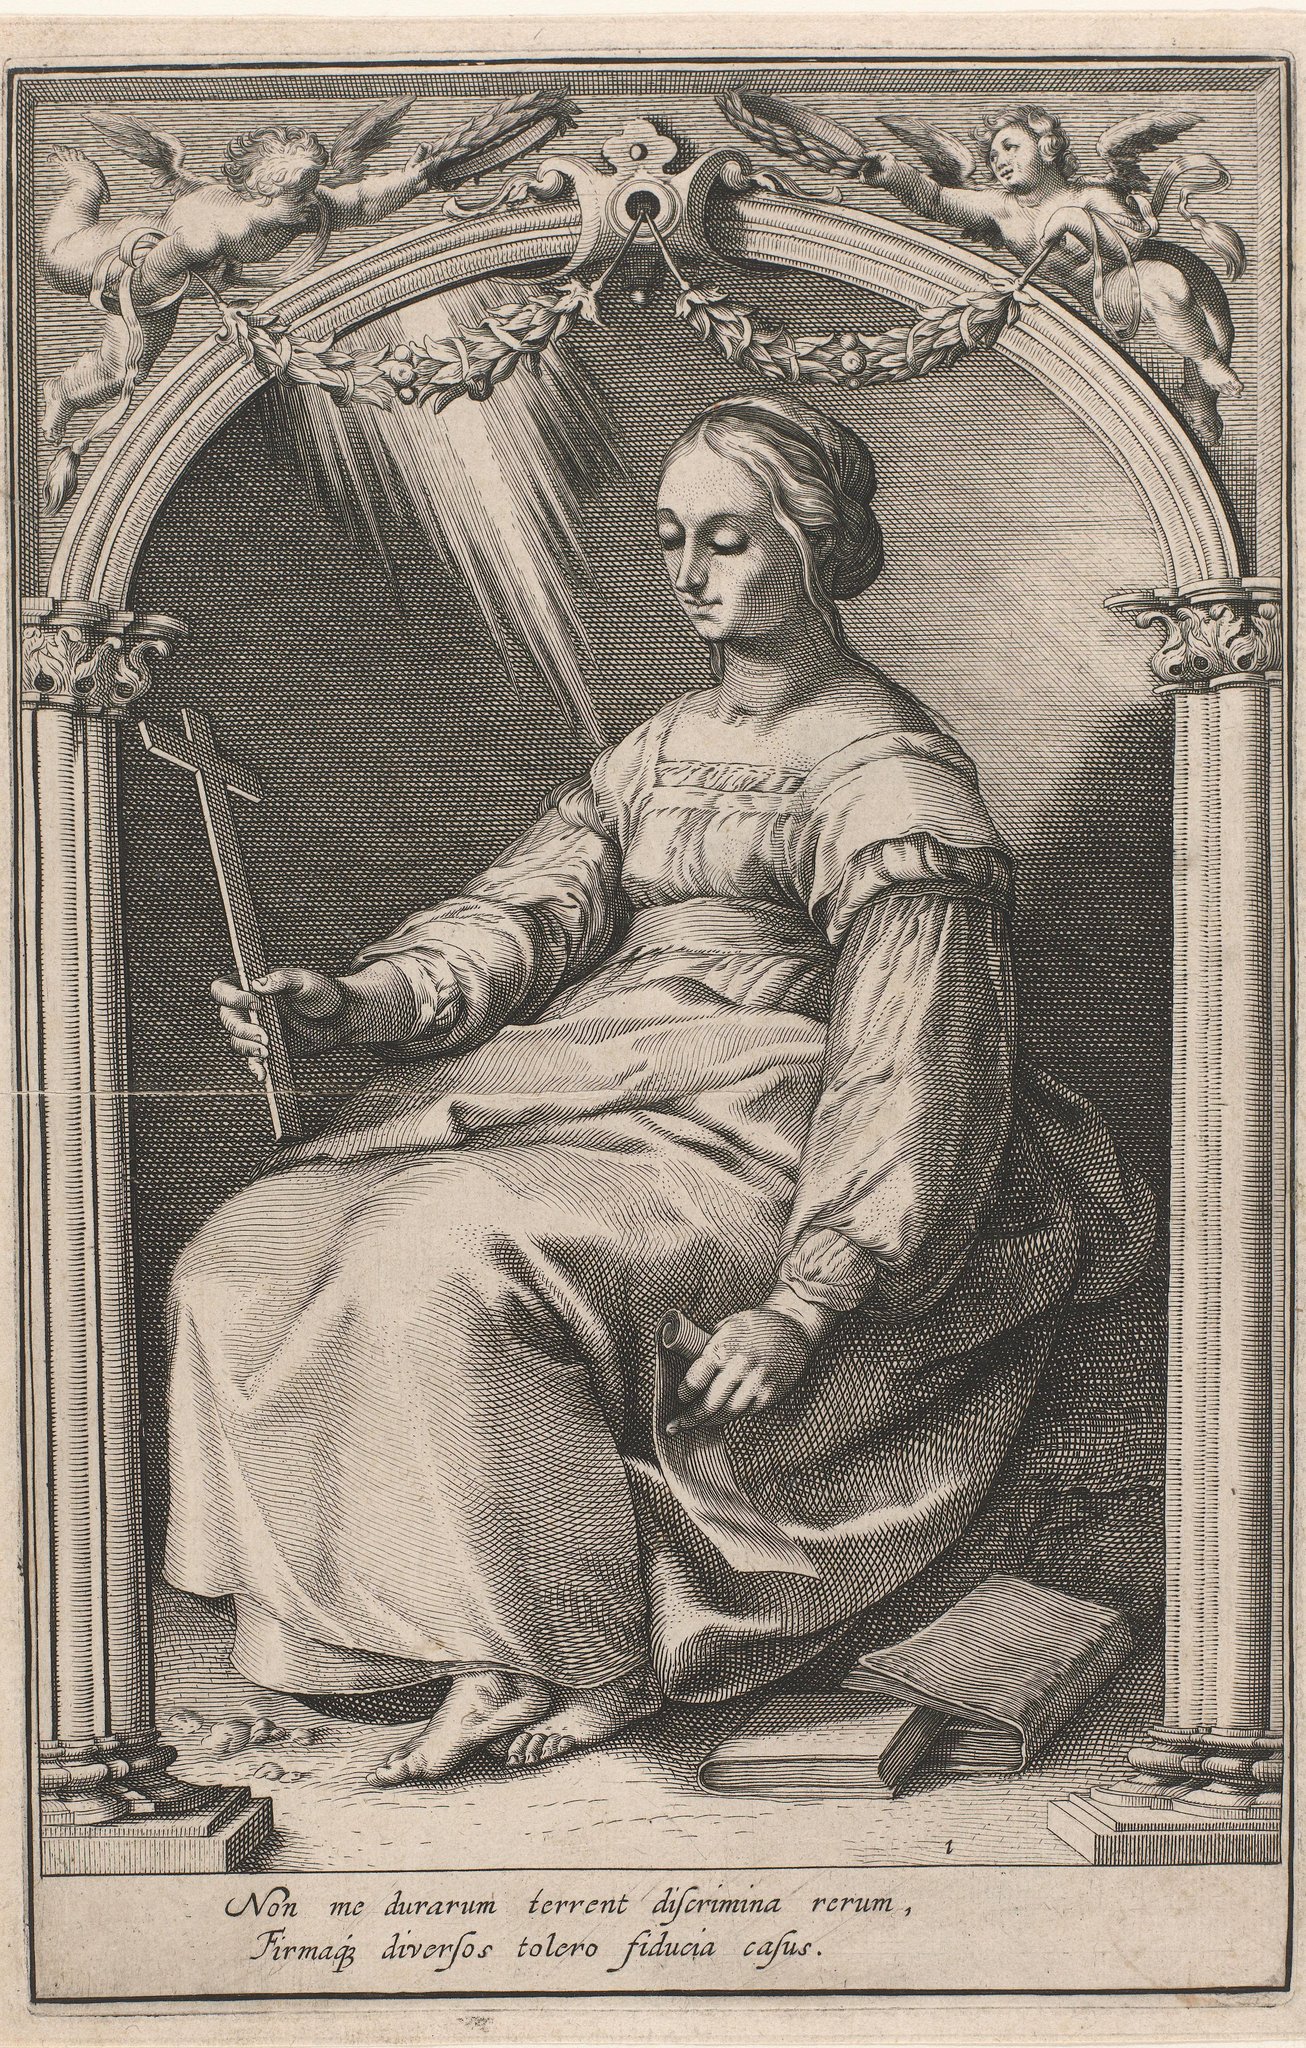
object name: print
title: De drie goddelijke deugden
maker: Anonymous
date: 1592-1667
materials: paper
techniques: engraving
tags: faith, 'fides'; 'fede', 'fede catholica', 'fede christiana', 'fede christiana catholica' (ripa) ~ one of the three theological virtues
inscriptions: collector's mark: Lugt 240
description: De personificatie van het Geloof, een van de drie goddelijke deugden, met een kruis in de hand. Naast haar liggen boeken. De voorstelling wordt omvat door een ornamentele boog met putti met lauwerkransen en guirlandes. Onder de voorstelling een tweeregelige tekst in het Latijn.